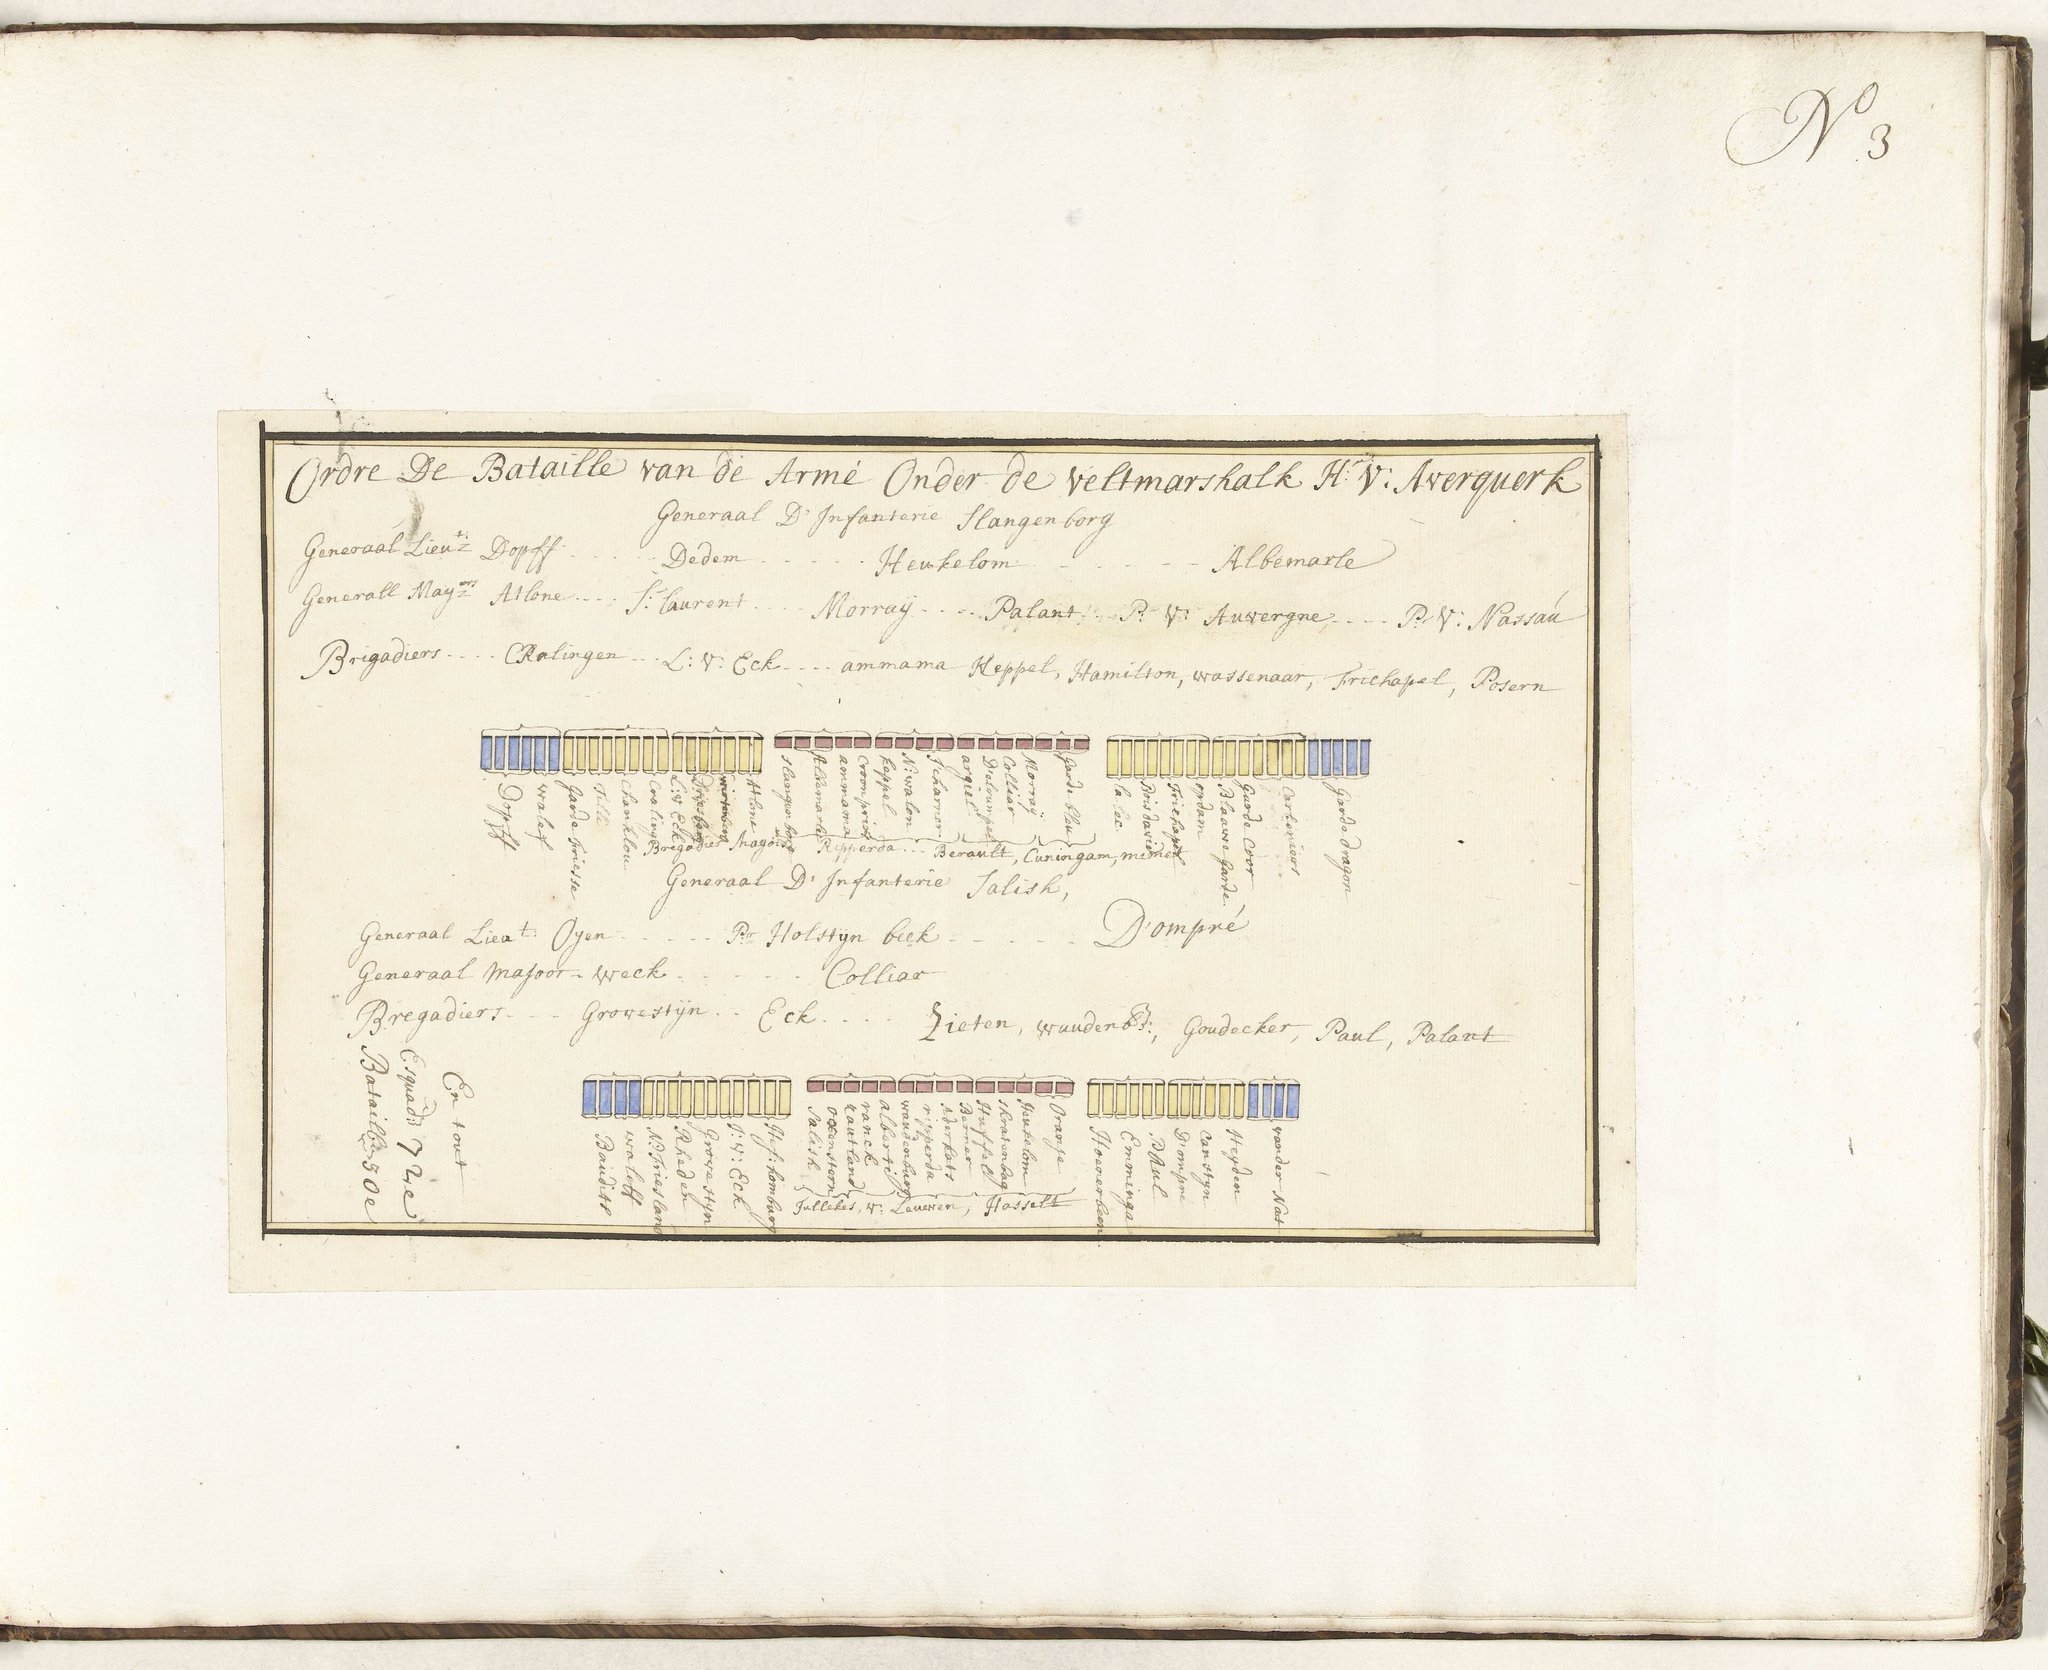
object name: map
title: Ordre De Bataille van de Armé Onder de veltmarschalk H: V: Auerquerk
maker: samuel du ry de champdoré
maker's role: draughtsman, engineer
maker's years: 1651-1729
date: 1701-1715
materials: paper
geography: netherlands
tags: the hague, (military) camp with tents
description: Slagorde van de het Geallieerde leger onder de Heer van Ouwerkerk, ca. 1701-1715. Onderdeel van een verzameling getekende plannen van versterkte plaatsen in Nederland en omringende landen ten tijde van de Spaanse Successieoorlog (deel D).